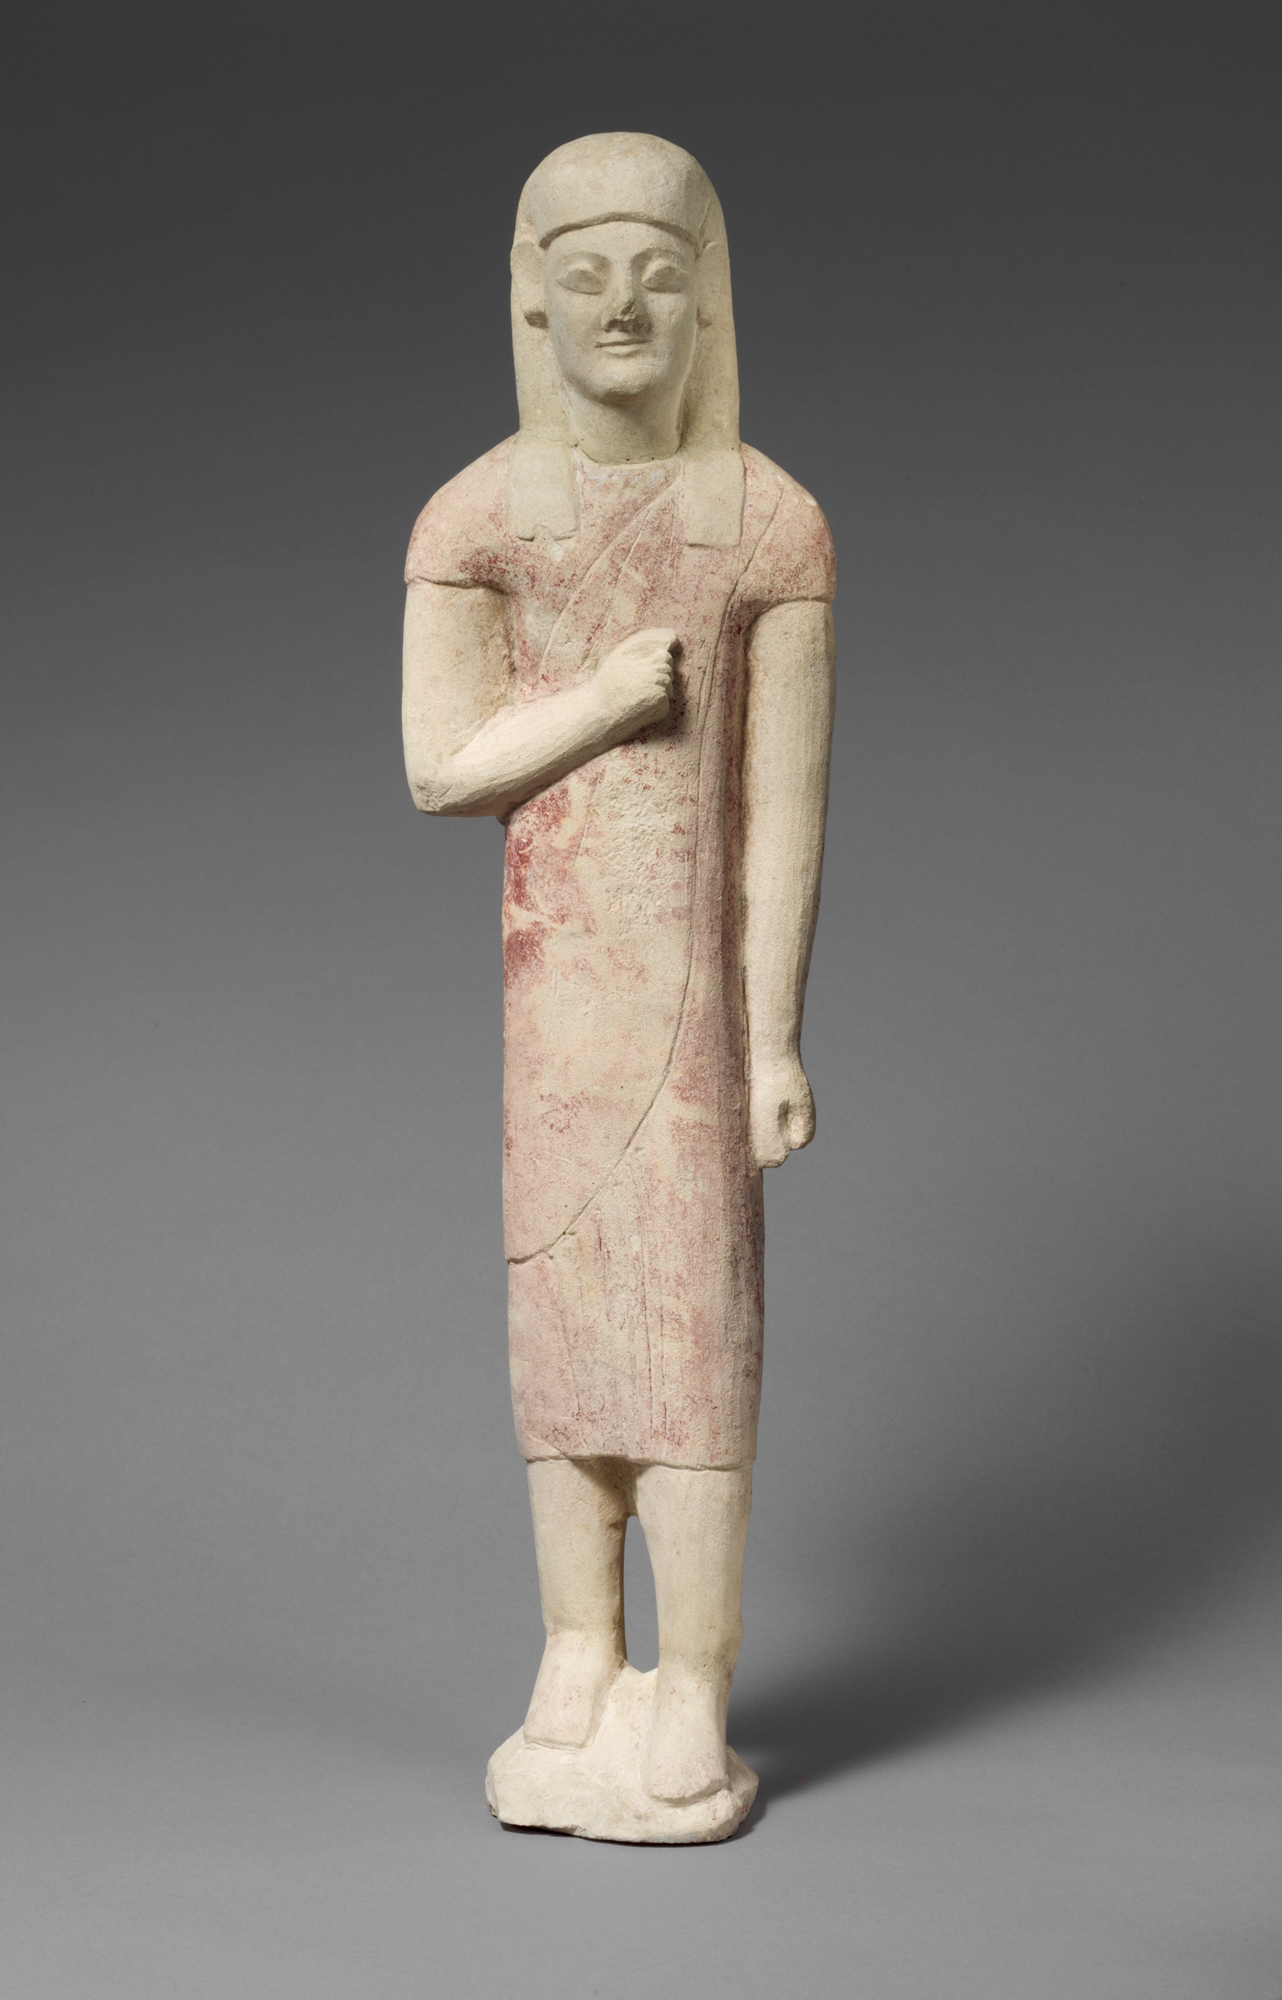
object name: statue of a votary, male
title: Limestone statuette of a beardless male votary in Greek dress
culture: cypriot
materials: limestone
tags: men